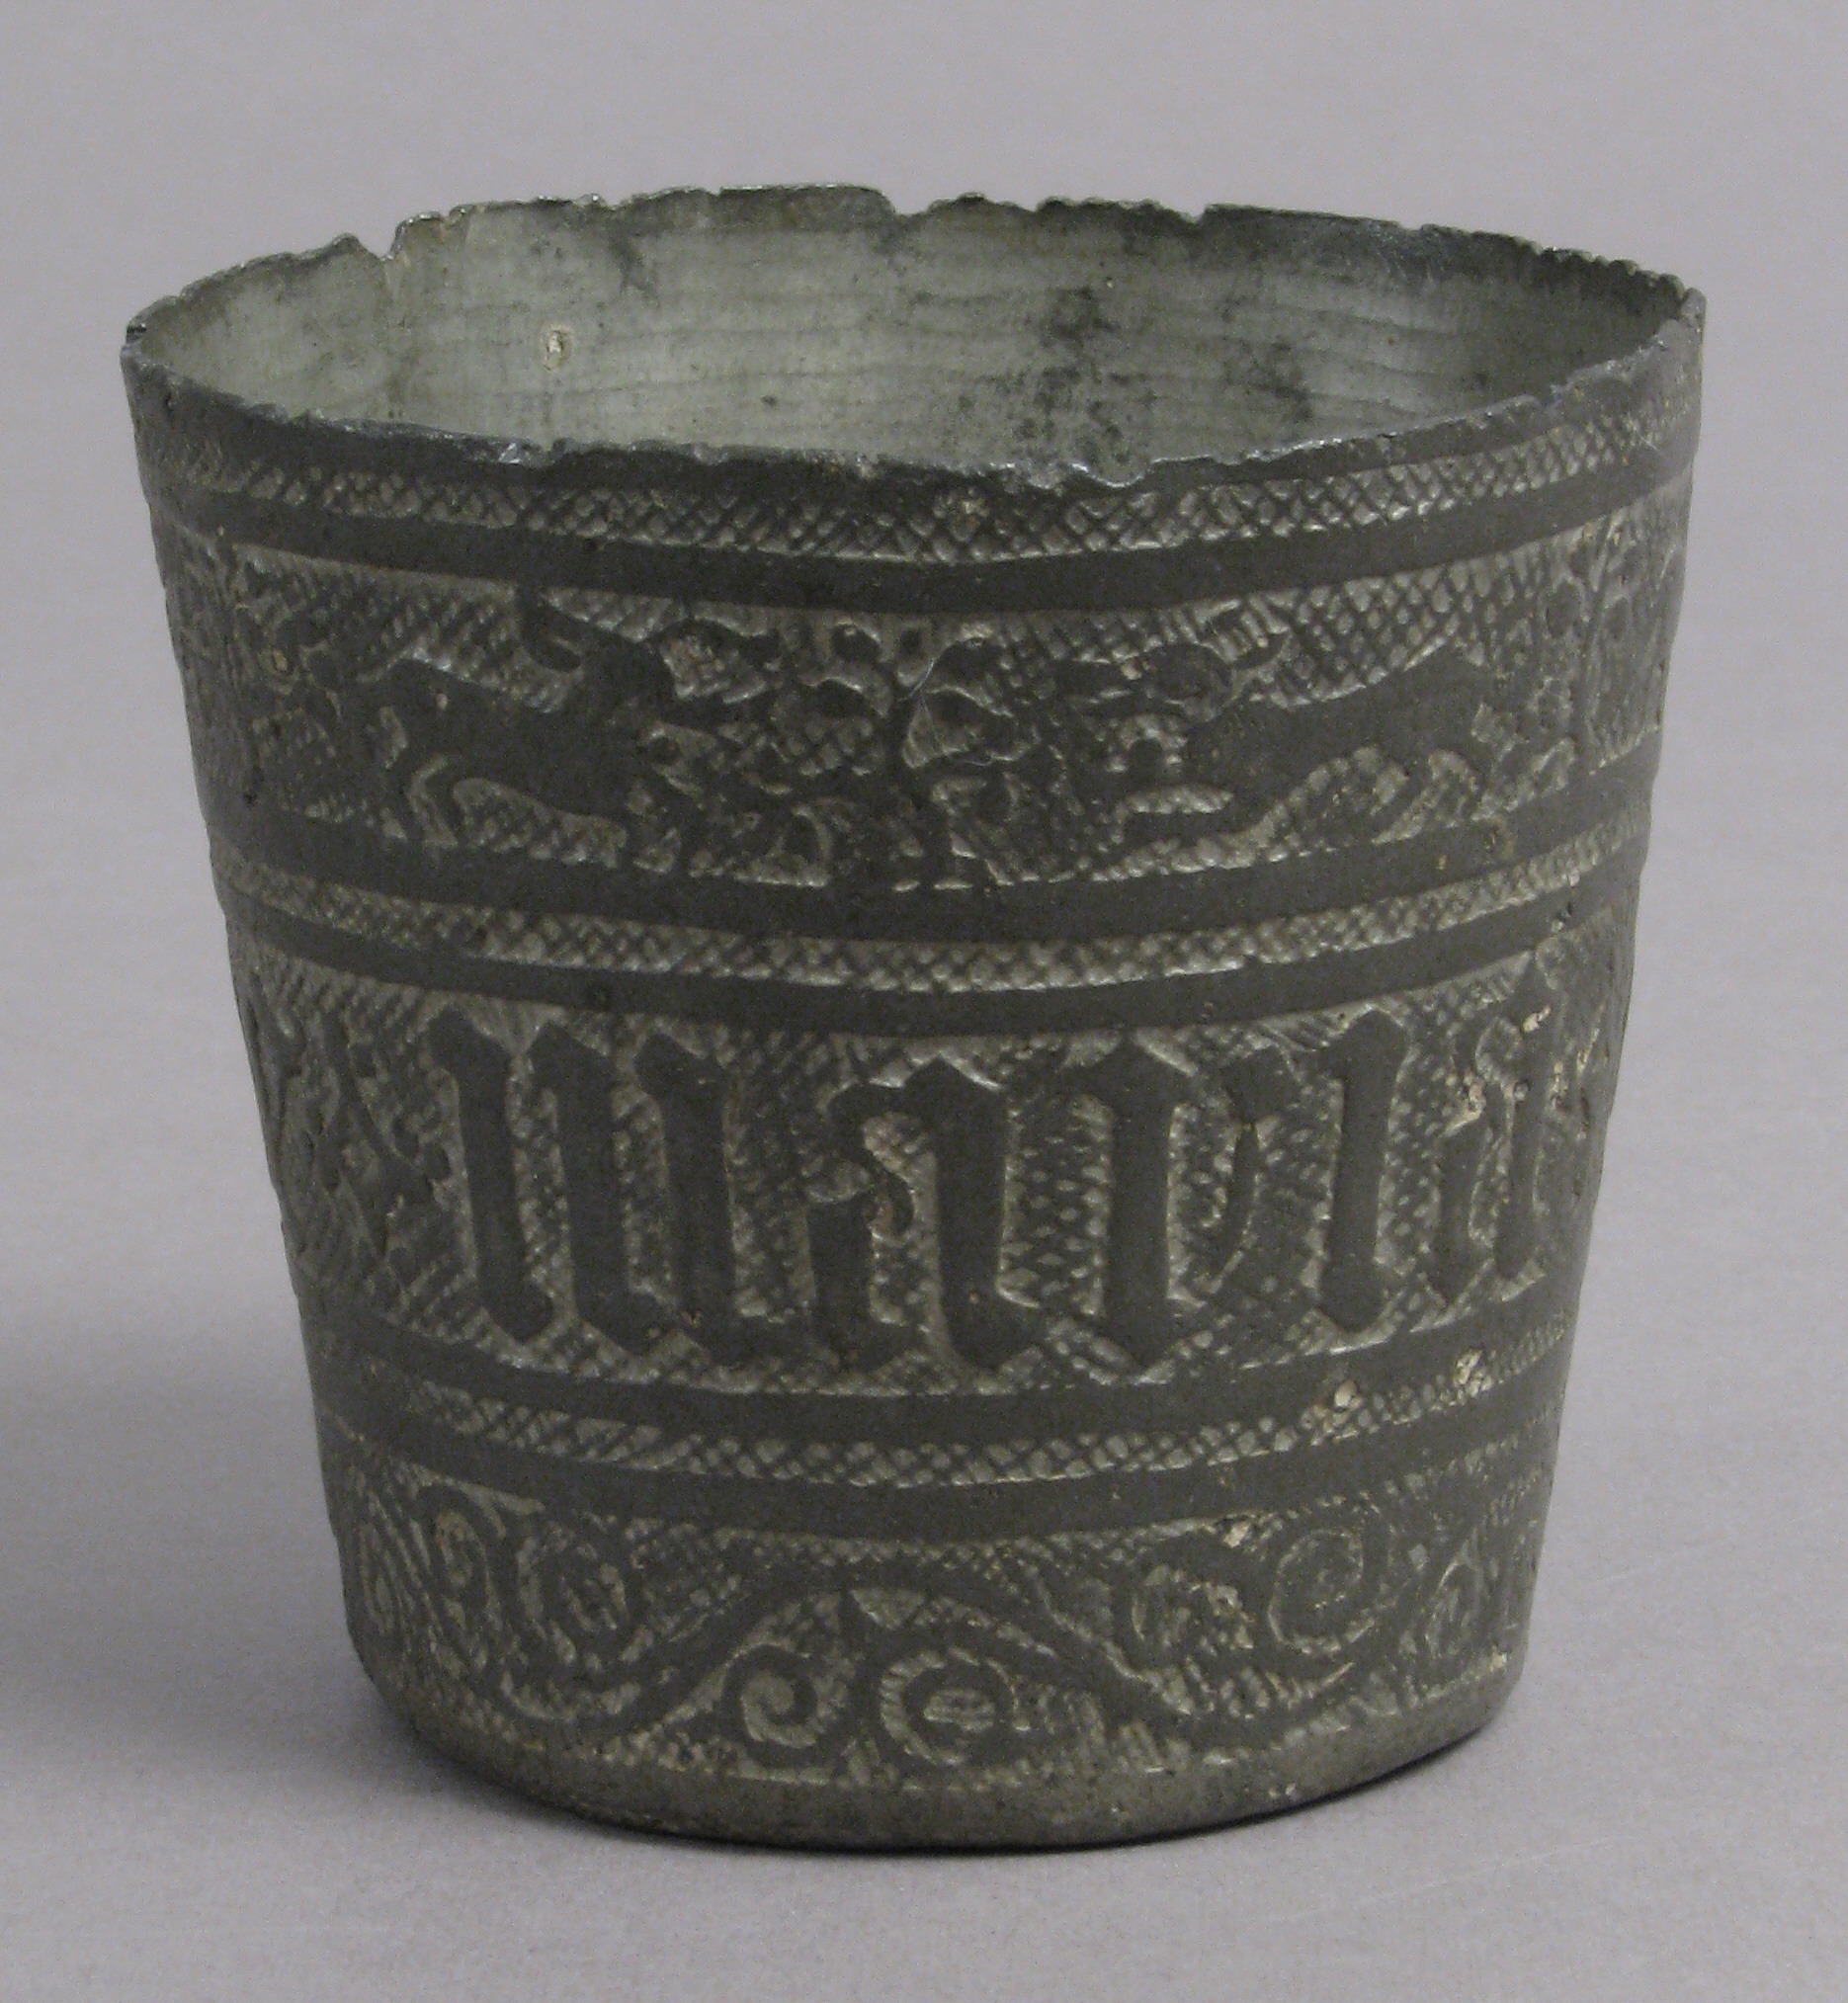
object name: beaker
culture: french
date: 1401-1500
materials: pewter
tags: animals